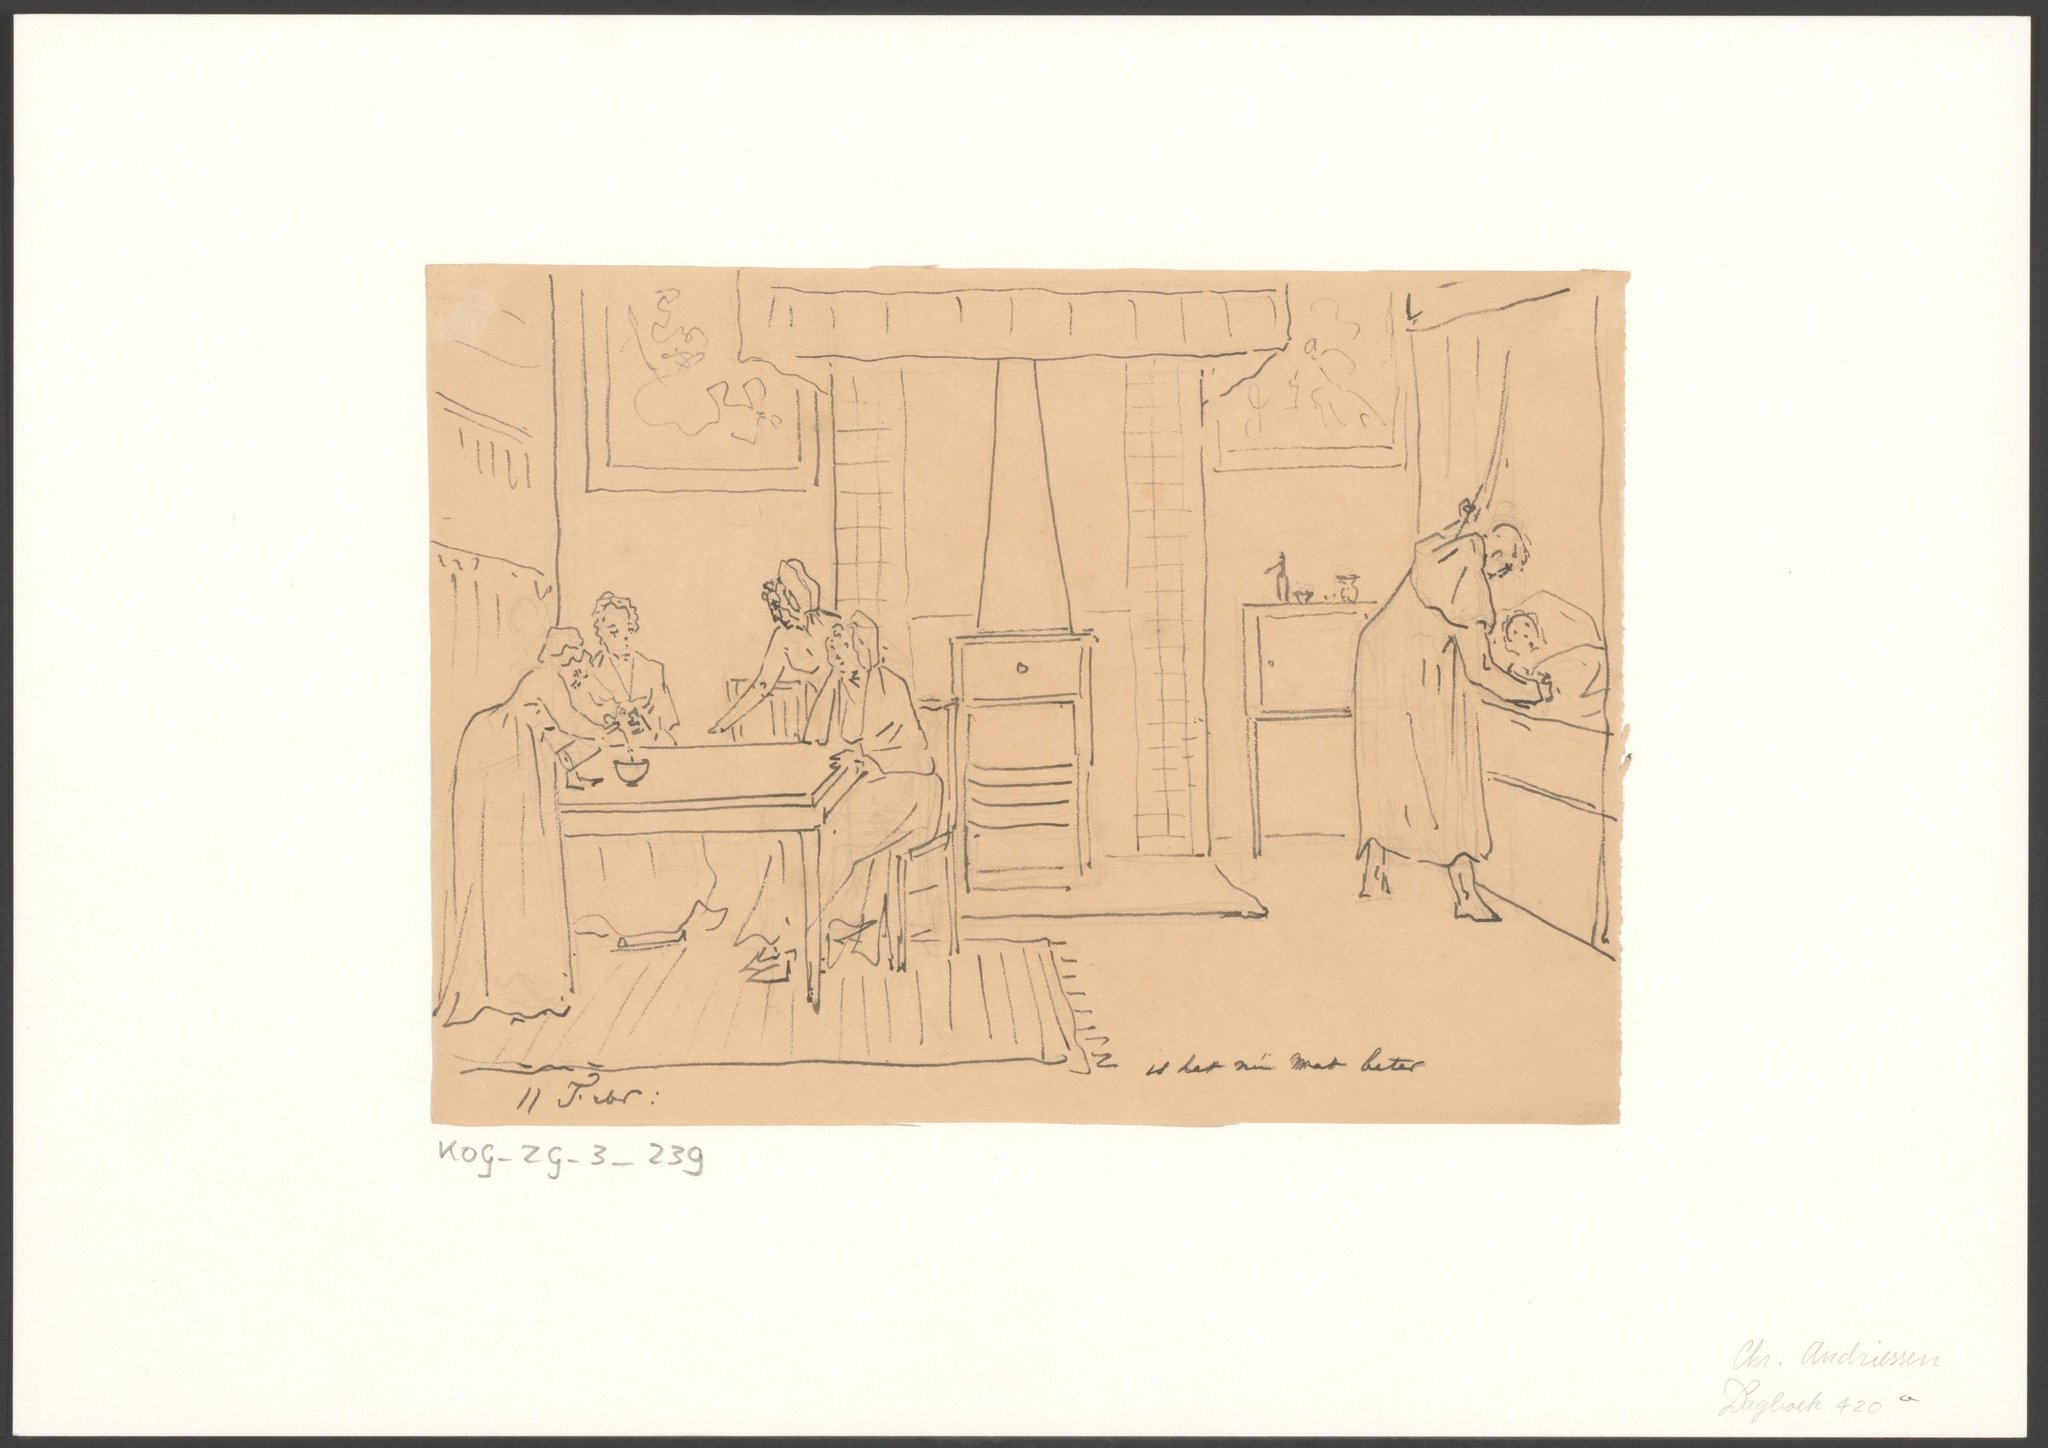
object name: drawing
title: Christiaan Andriessen aan een ziekbed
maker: christiaan andriessen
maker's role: draughtsman, print maker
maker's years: 1775-1846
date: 1805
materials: ink, paper, pencil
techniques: pen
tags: sick-bed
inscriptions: inscription: ‘11 febr: is het nu wat beter’, signature: ‘J Andriessen’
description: Dagboekblad uit het getekende dagboek dat Christiaan Andriessen bijhield van 1805 tot en met 1808.